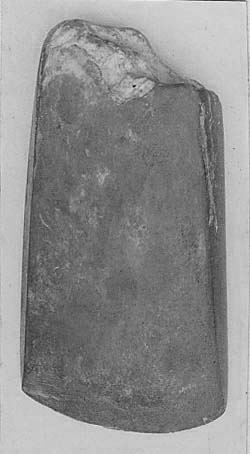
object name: hatchet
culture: german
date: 1902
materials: jade